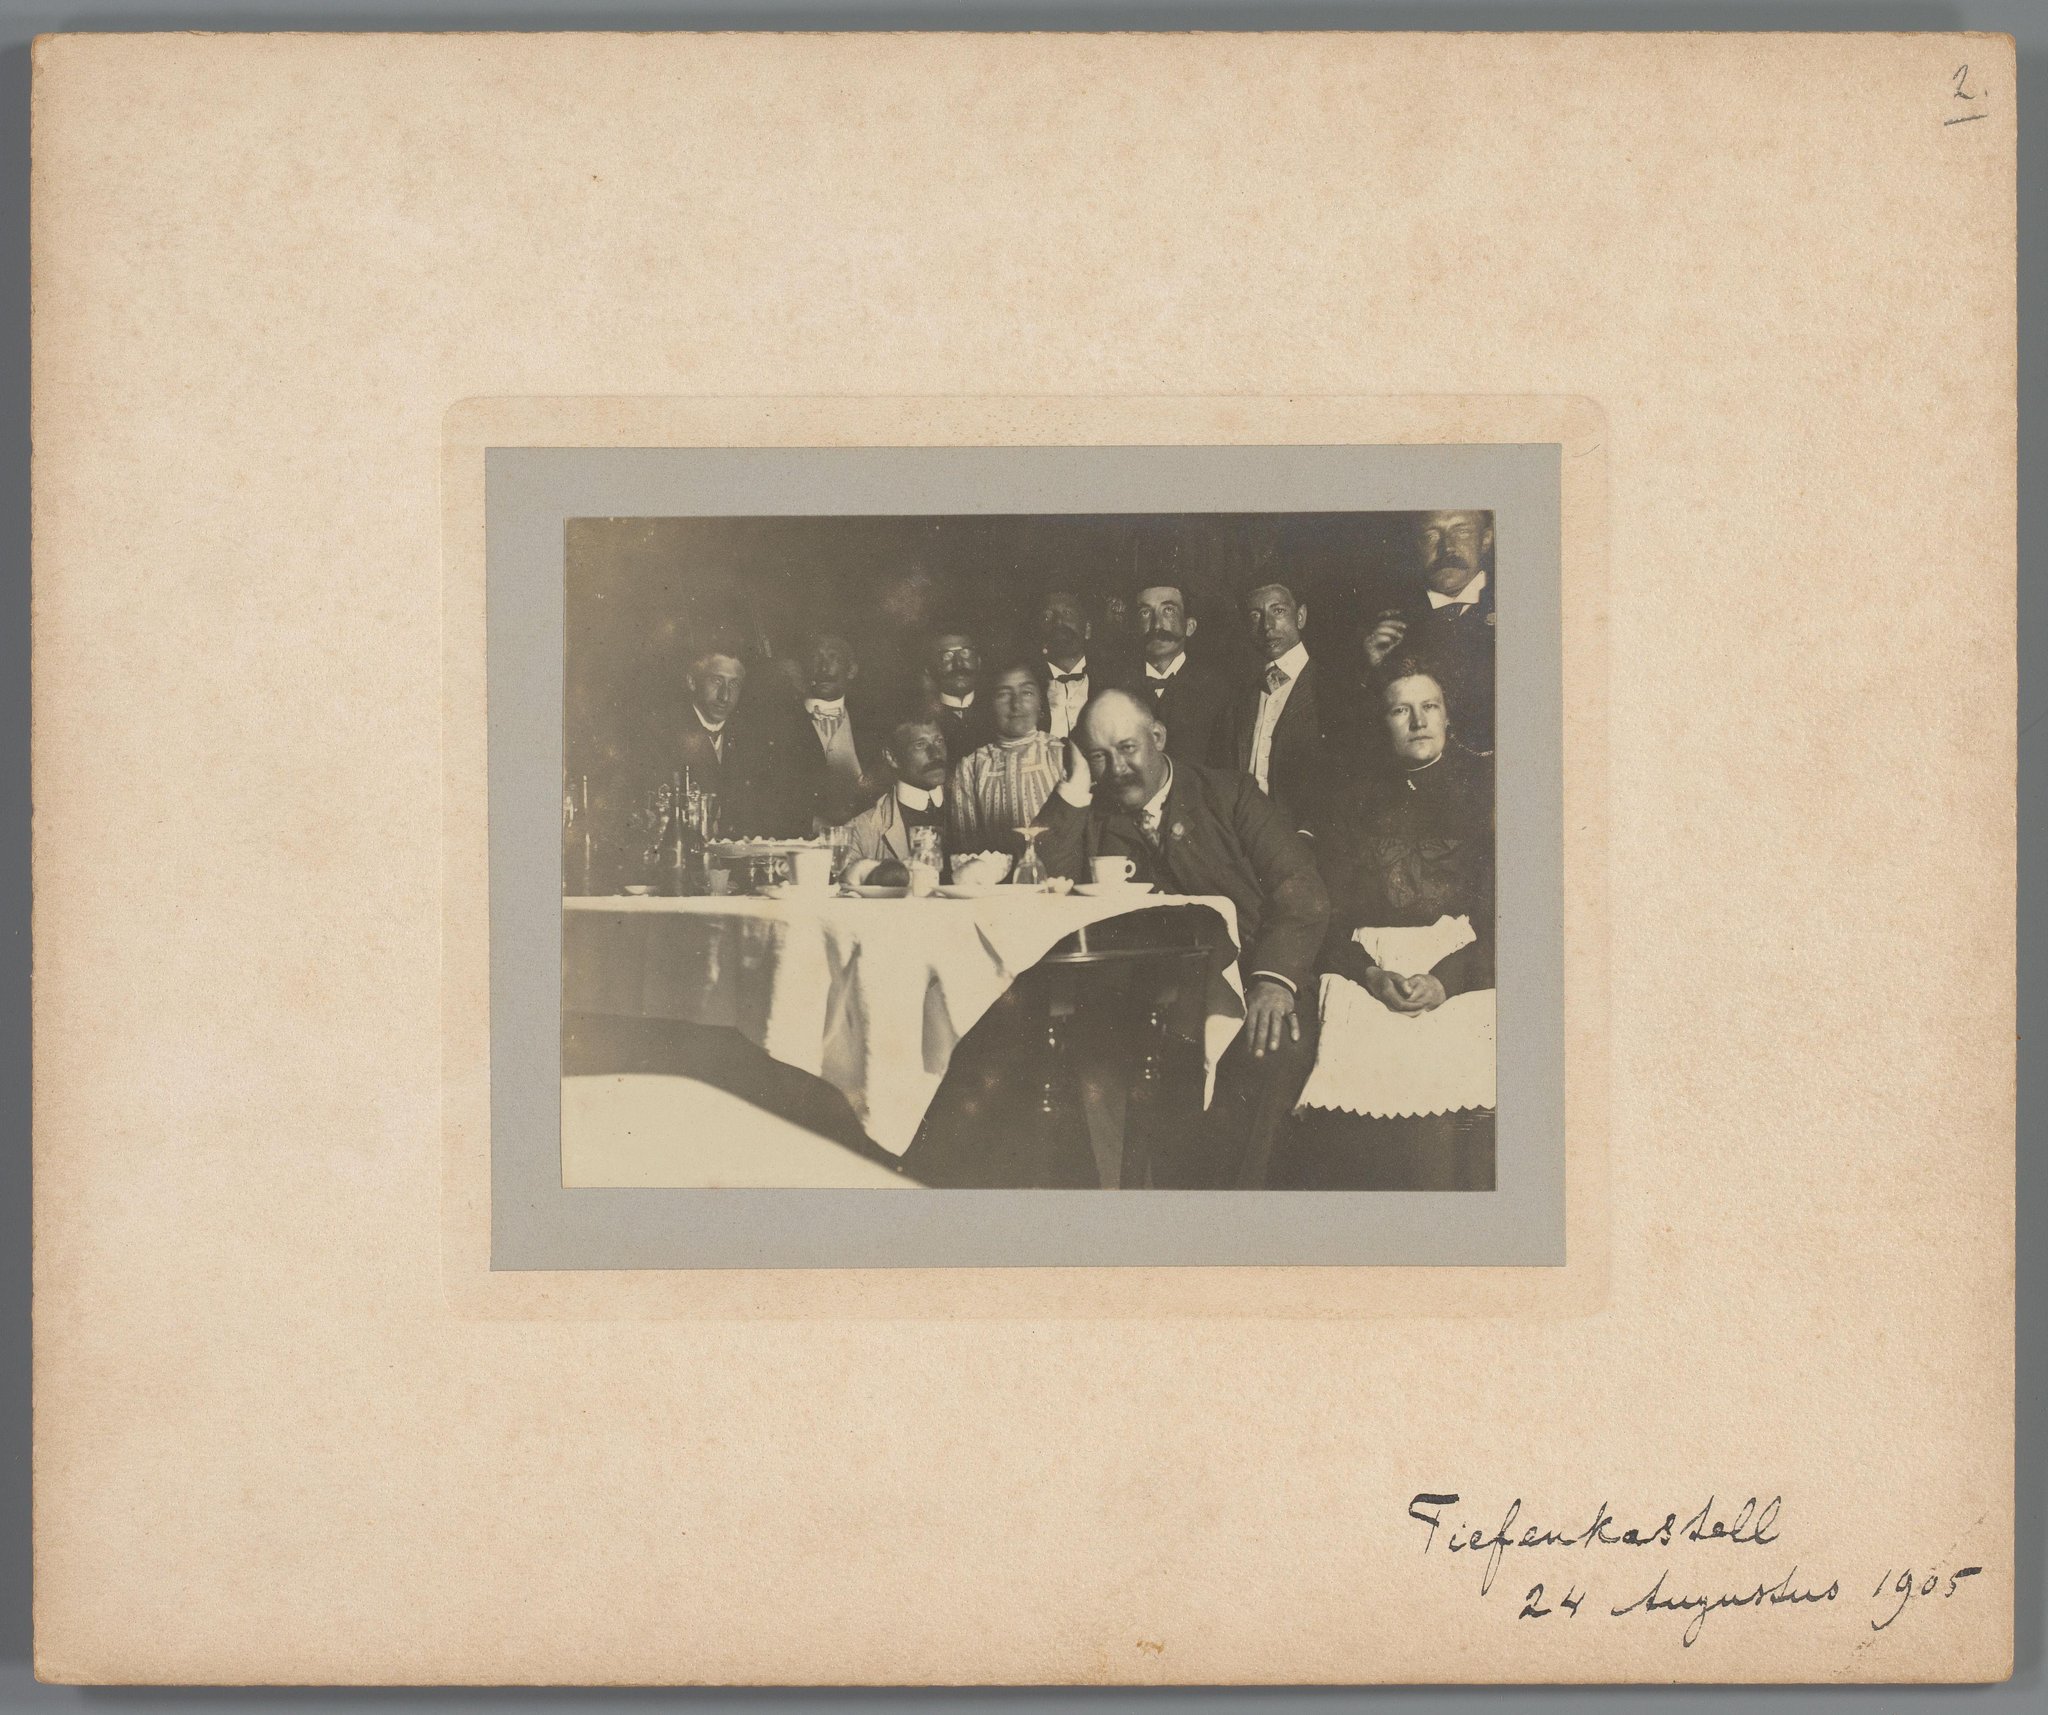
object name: photograph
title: Tiefenkastell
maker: françois buys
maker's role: advocaat, amateurfotograaf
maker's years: 1871-1934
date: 1905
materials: paper, cardboard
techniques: gelatin silver print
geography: tiefencastel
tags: inn, coffee-house, public house, etc., anonymous historical persons portrayed in a group, in a group-portrait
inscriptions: number: ‘2’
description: Deze foto maakt deel uit van een groep van 38 foto's.